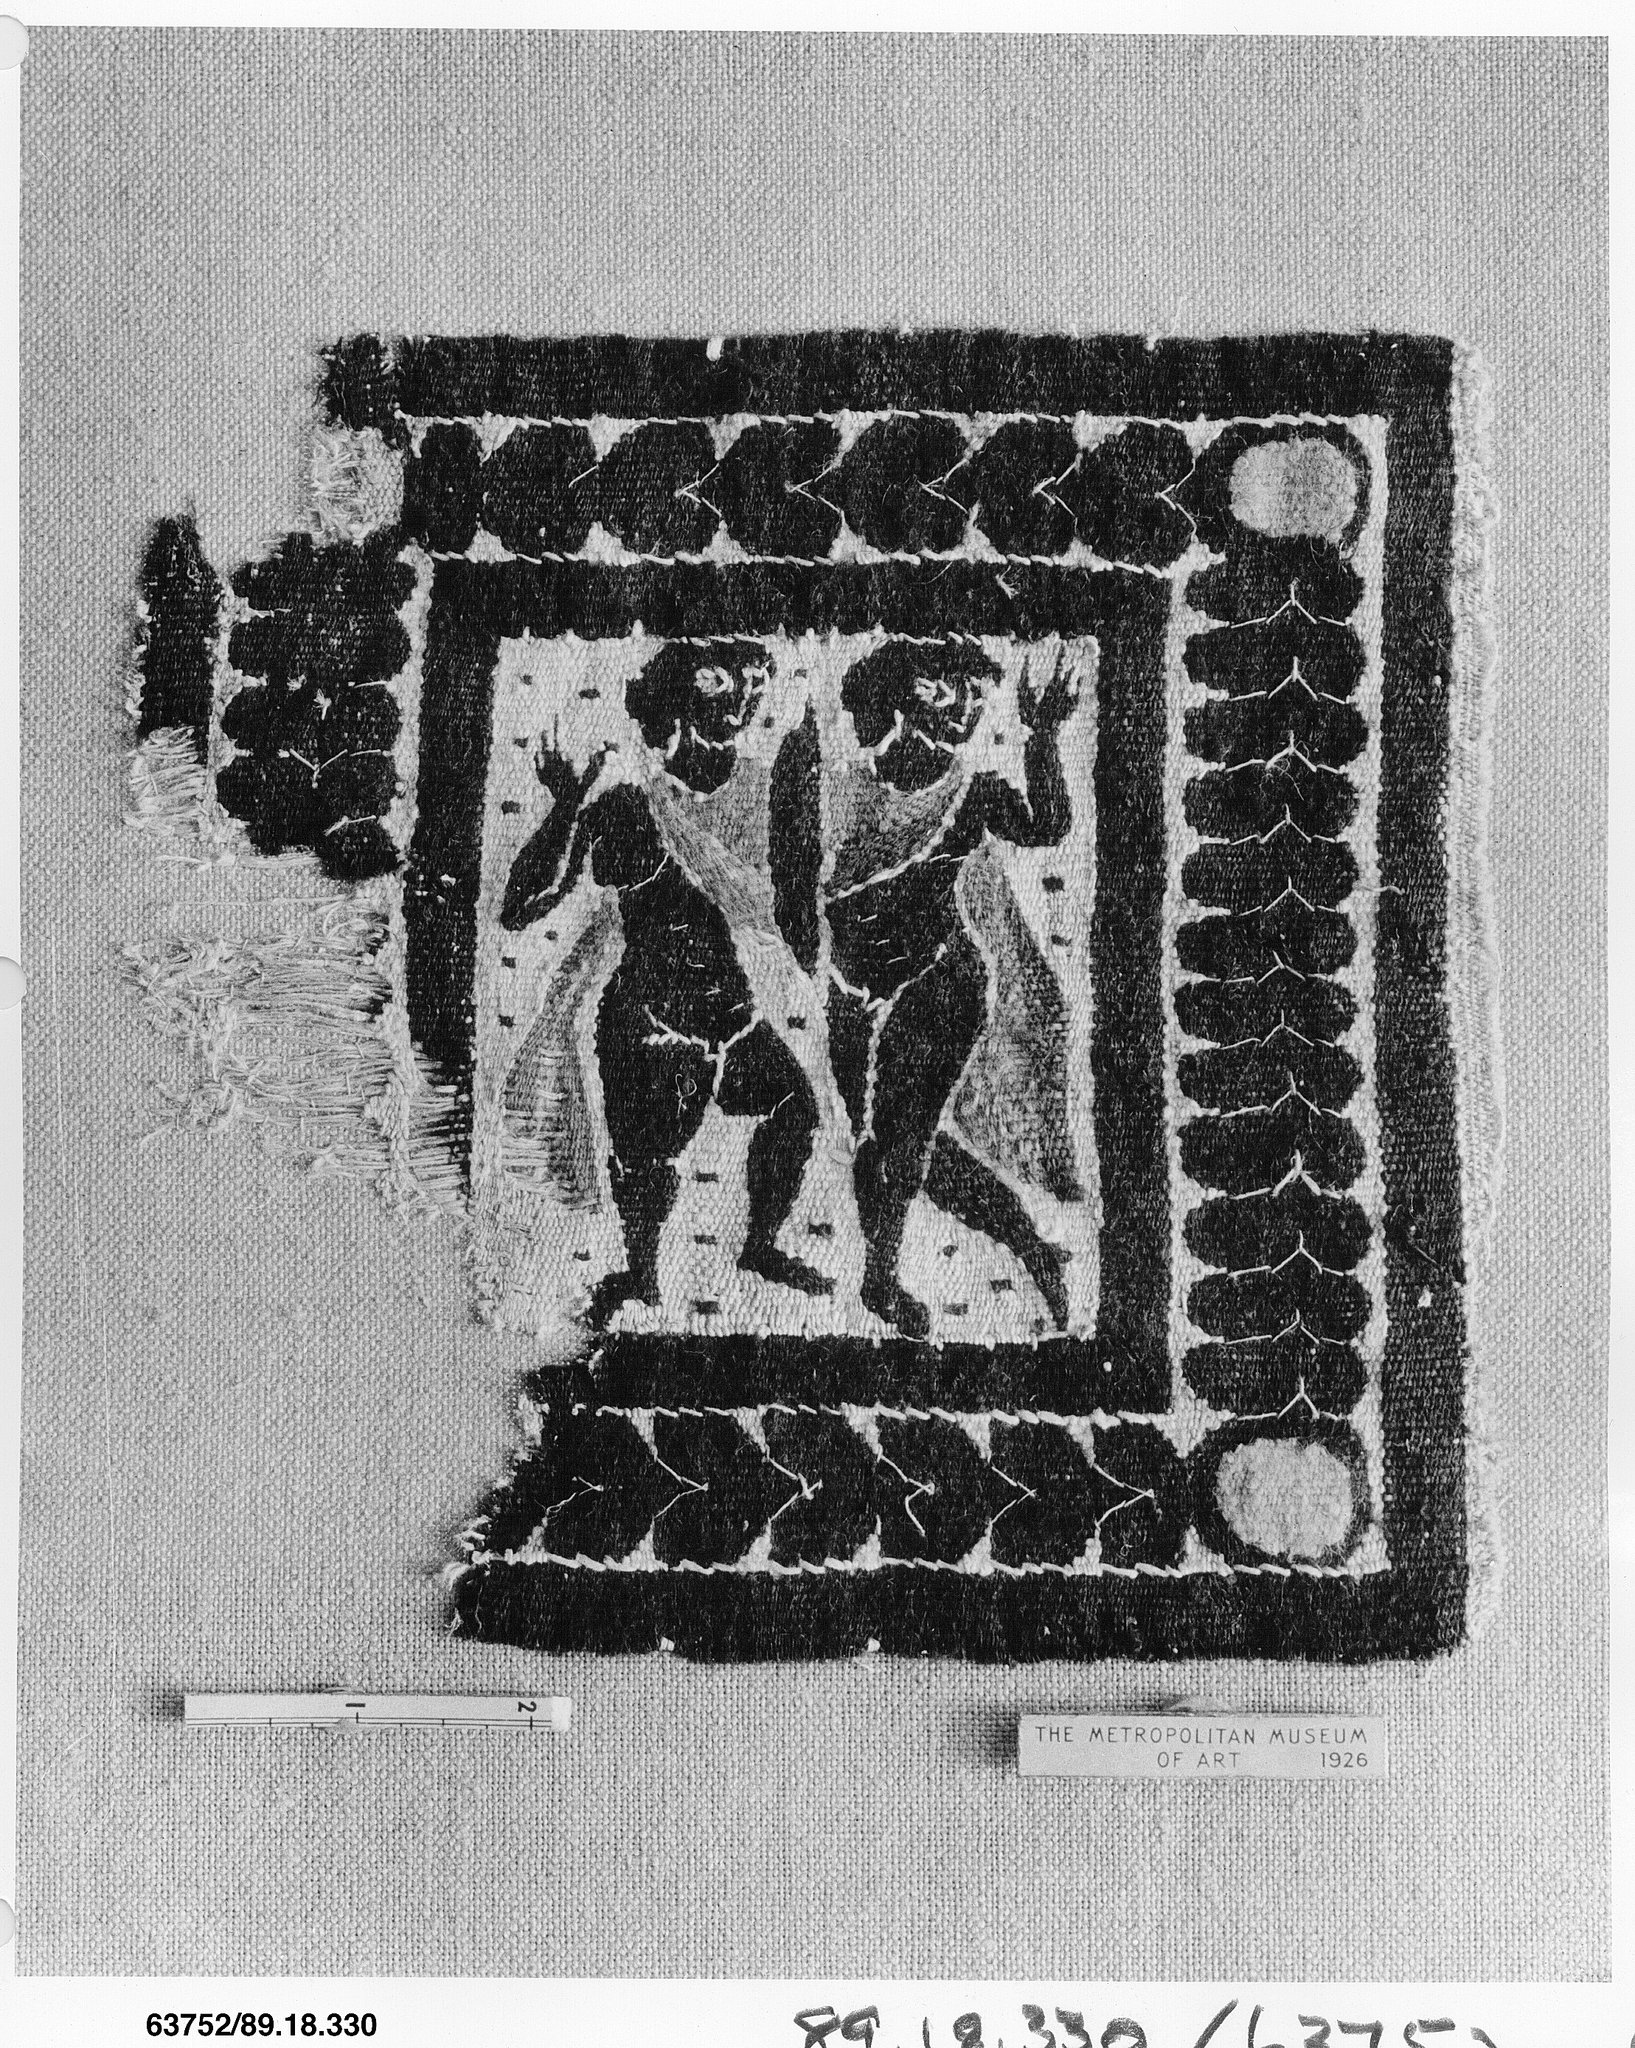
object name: textile fragment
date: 201-400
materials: linen, wool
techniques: weave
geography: egypt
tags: human figures